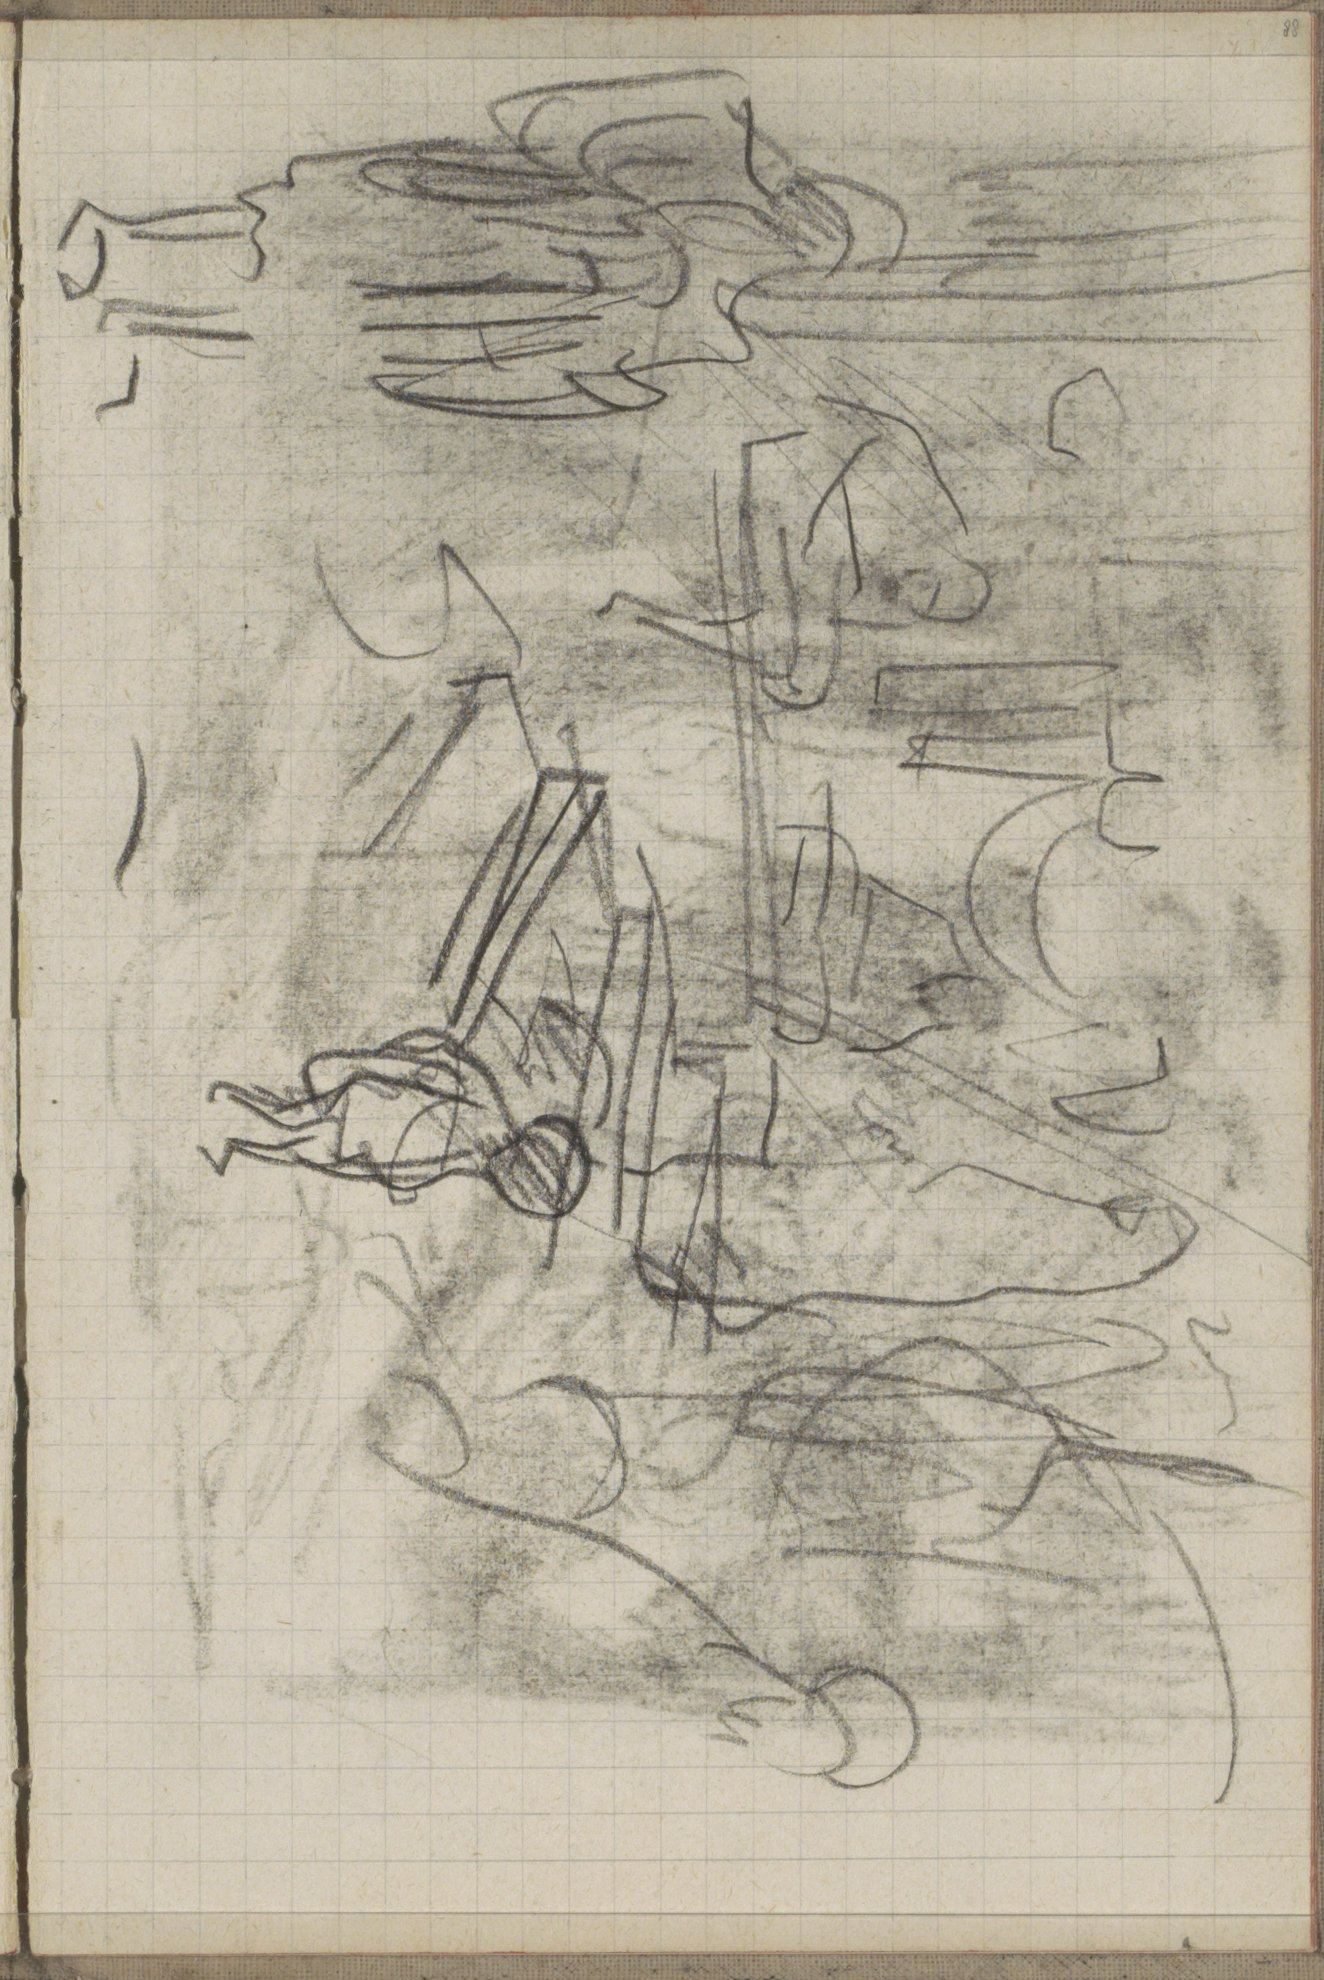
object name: sketchbook leaf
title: Figuren op een straat, waaronder een kind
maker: marius bauer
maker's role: draughtsman, print maker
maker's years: 1867-1932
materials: chalk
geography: istanbul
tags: child, street (+ city(-scape) with figures, staffage)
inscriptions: kleurnotitie, handgeschreven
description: Pagina 88 uit een schetsboek met 54 bladen.